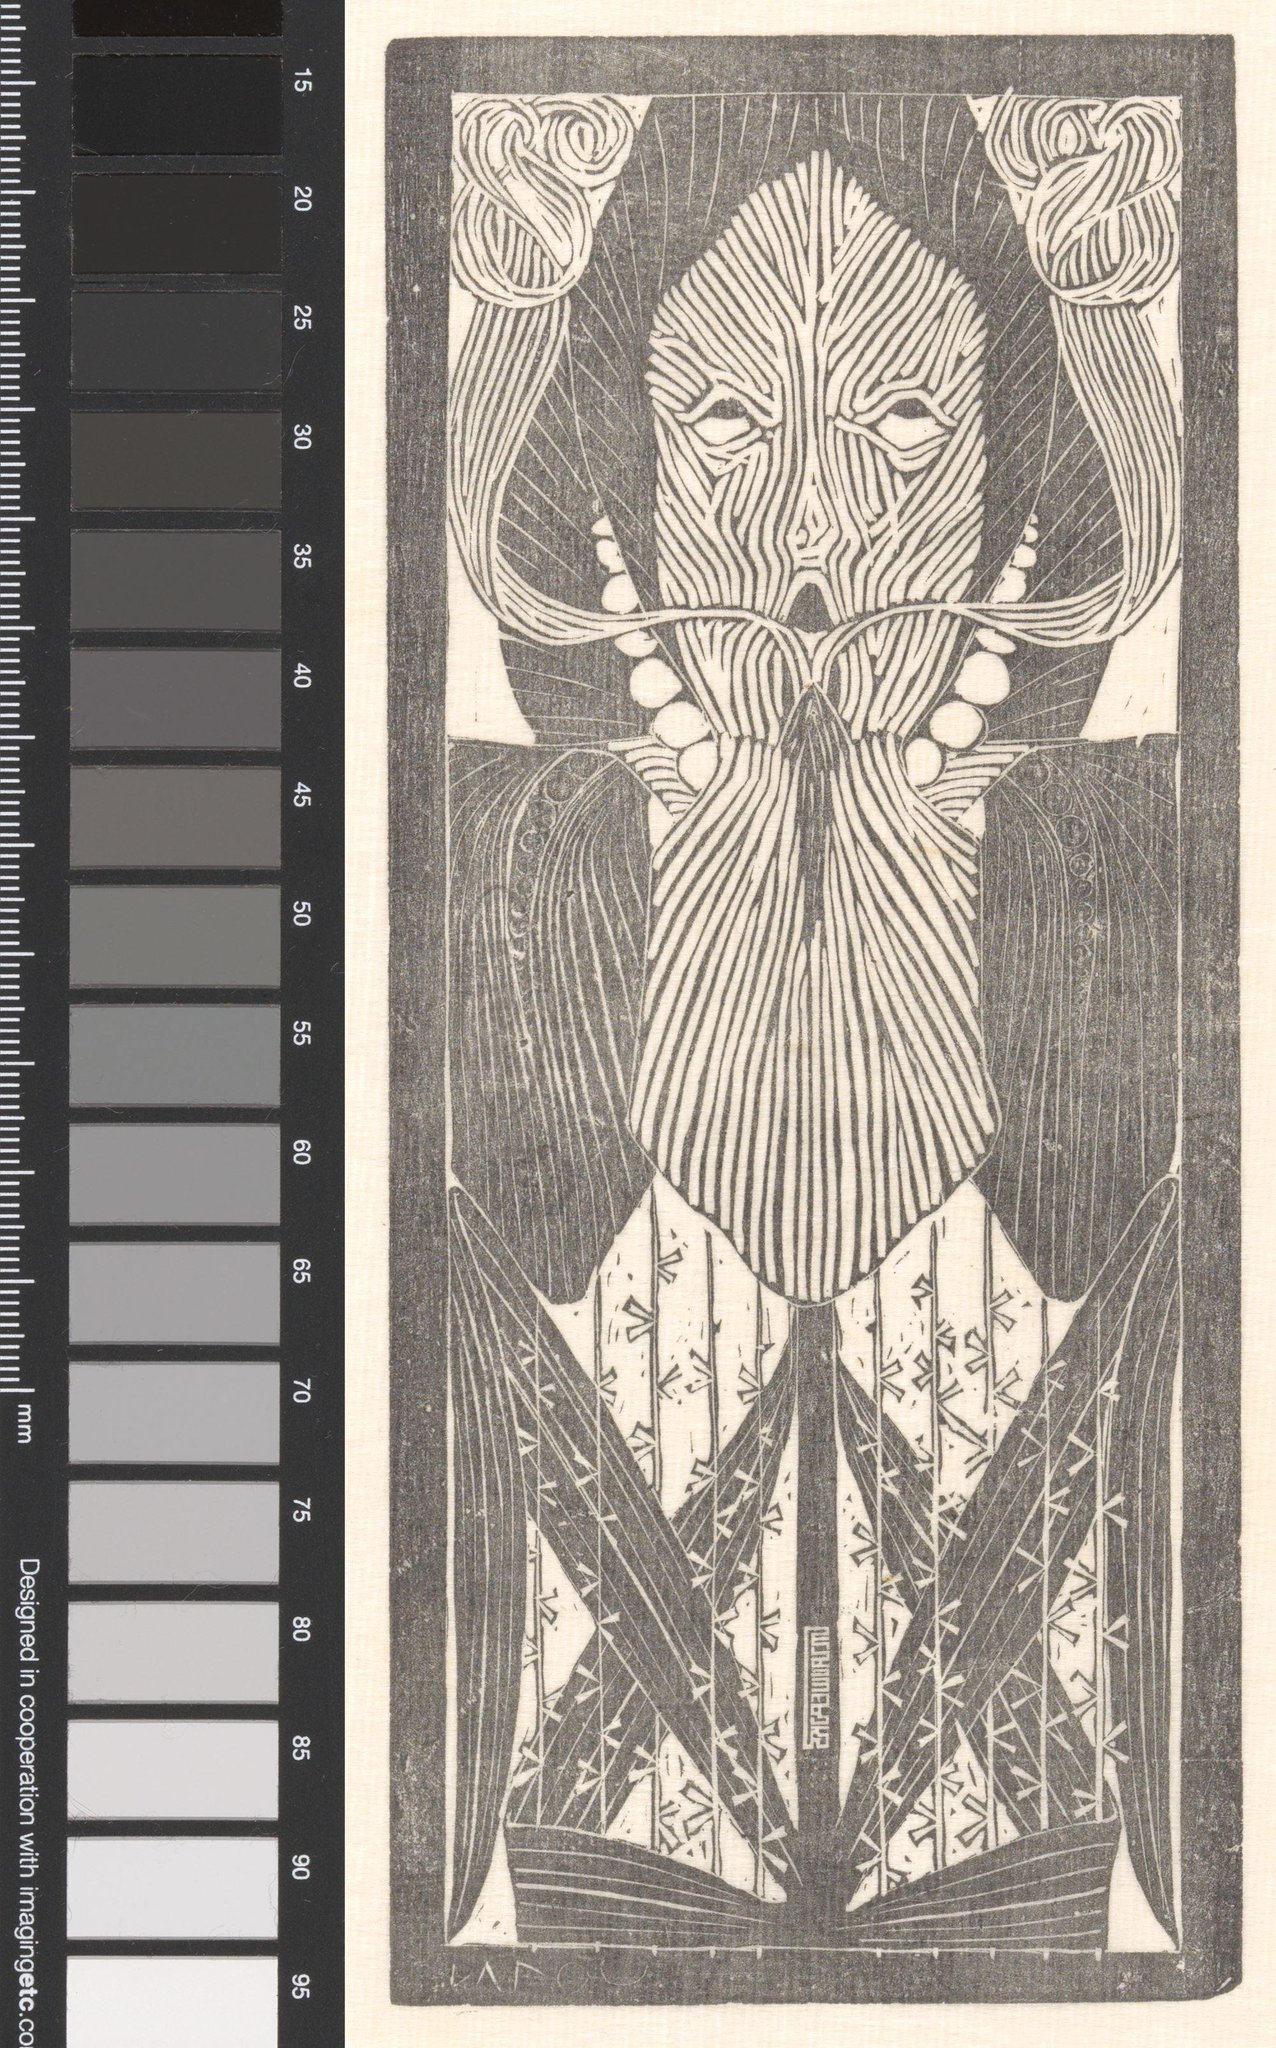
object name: print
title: Bloemgezicht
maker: mathieu lauweriks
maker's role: designer, draughtsman, print maker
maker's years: 1864-1932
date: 1894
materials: paper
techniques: woodcut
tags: flowers, face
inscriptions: collector's mark: Lugt 2228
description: Prent is mogelijk gebruikt voor: Licht en waarheid. Orgaan van de vereeniging 'Wie Denkt Overwint'. Amsterdam: Wie Denkt Overwint, 1 december 1894.